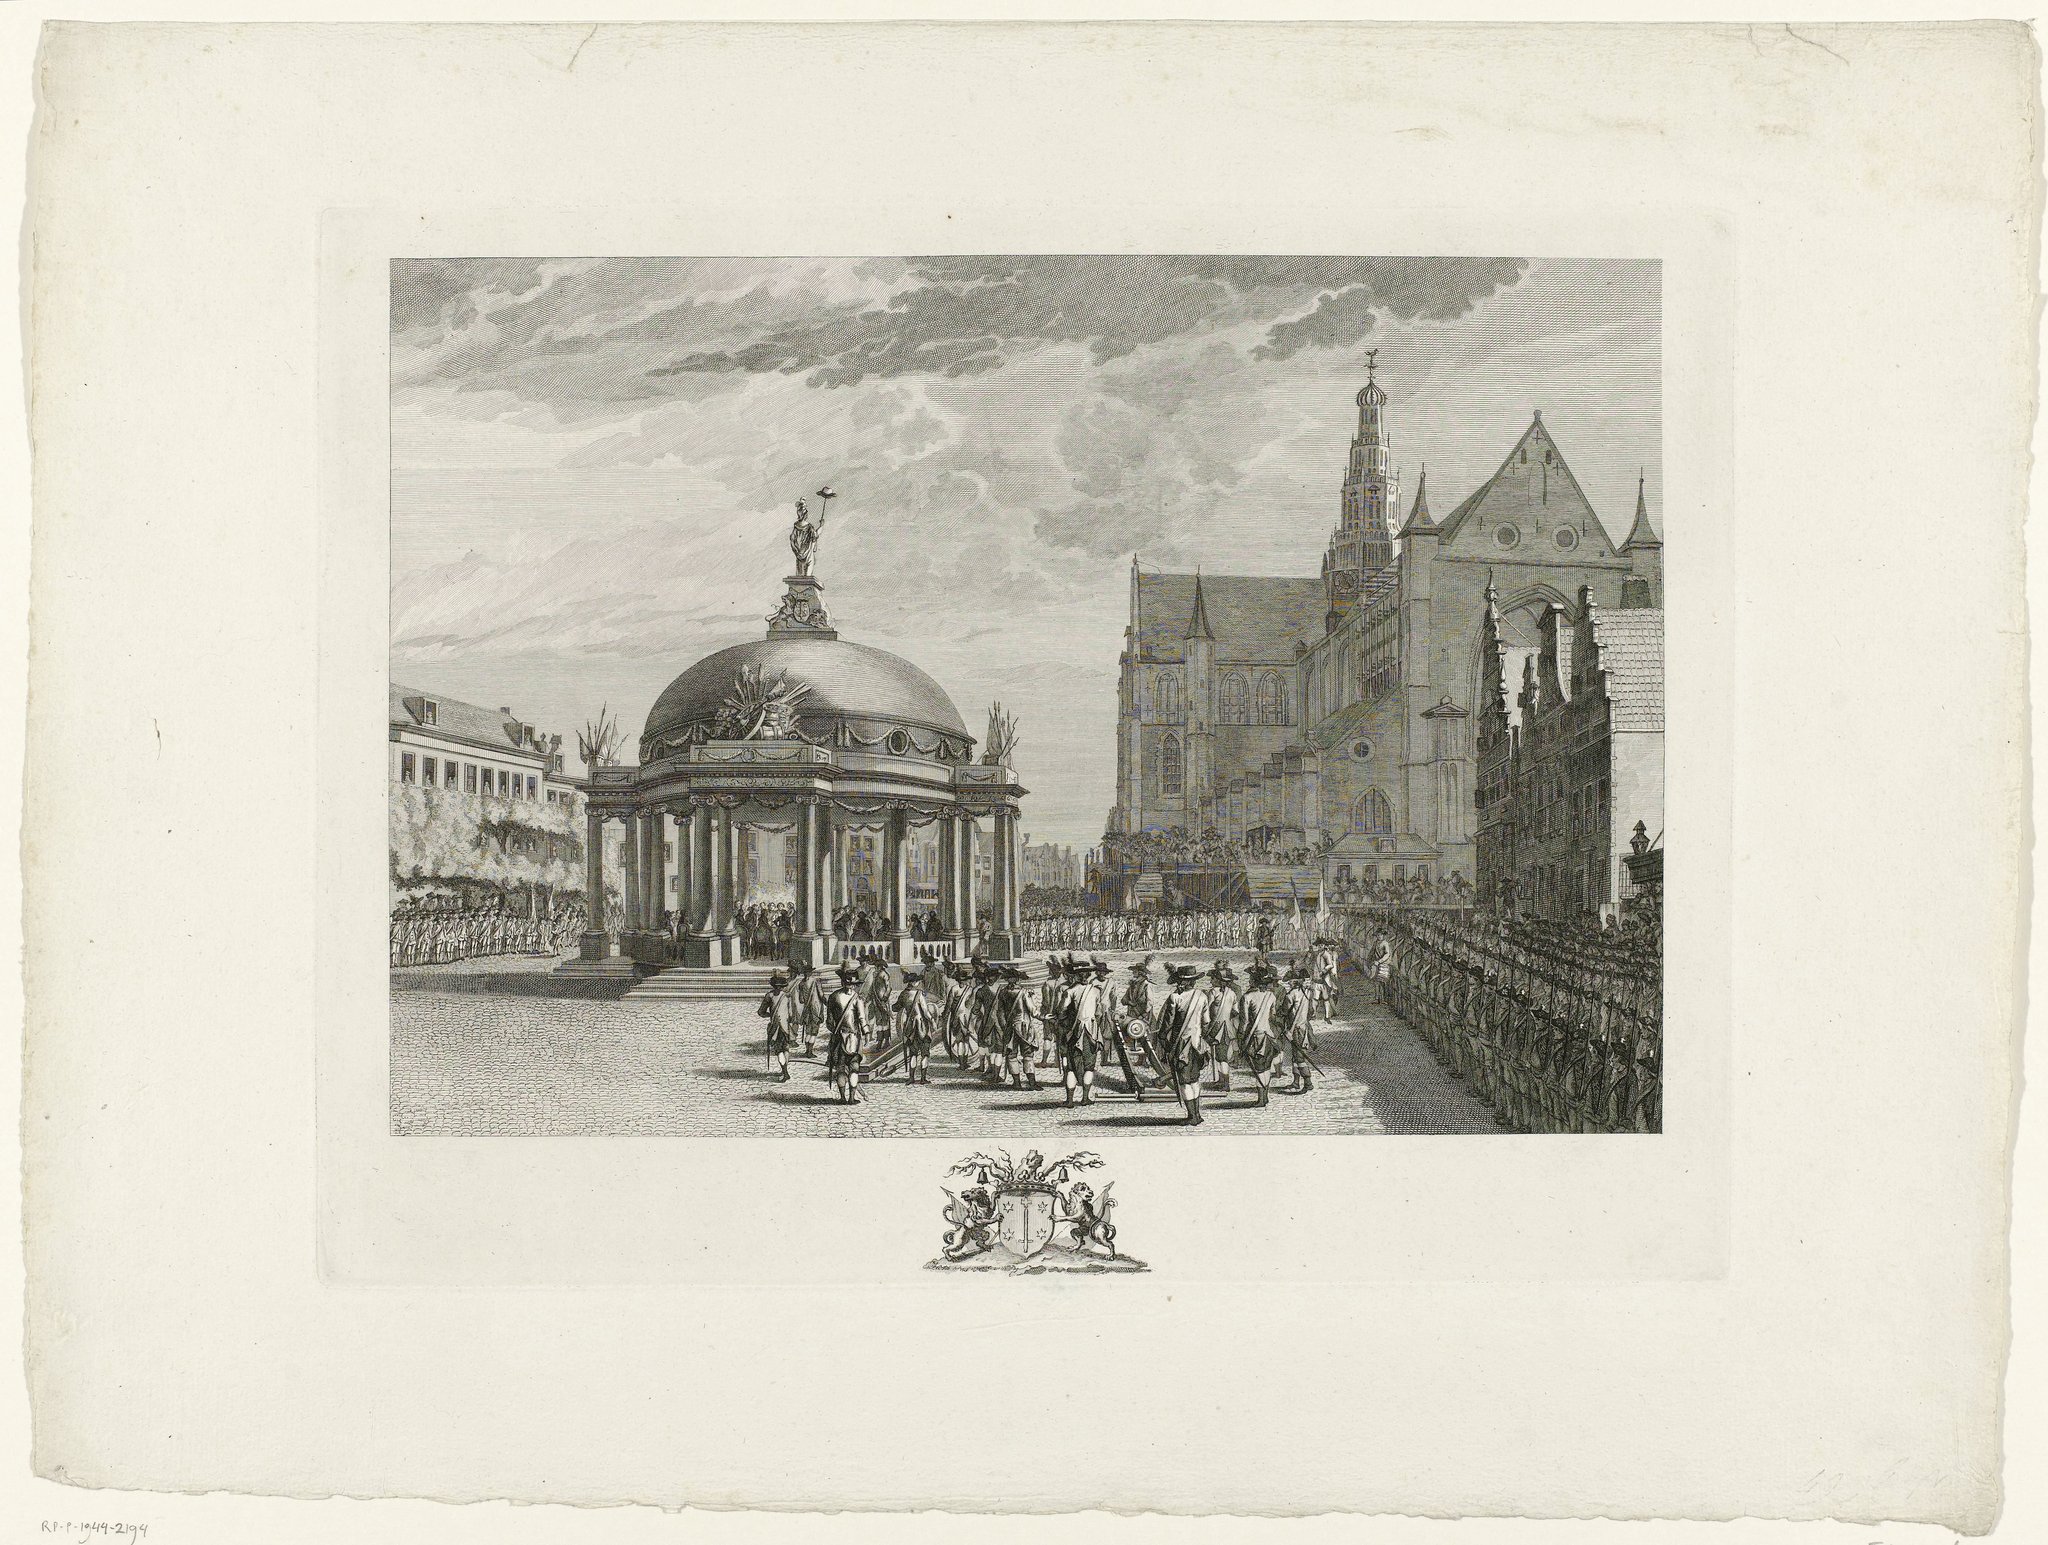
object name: print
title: Beëdiging van het regeringsreglement in Haarlem, 1787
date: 1787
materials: paper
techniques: engraving, etching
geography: northern netherlands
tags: proclamation of new government, warfare; military affairs (+ citizen soldiery, civil guard, citizen militia), patriots (1780-1795)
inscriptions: collector's mark: Lugt 2228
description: Plechtige ceremonie met de beëdiging van het nieuwe regeringsreglement in een tempel opgericht op de Grote Markt te Haarlem, 5 september 1787. Om het plein staan schutterijen opgesteld, bij de tempel enkele stukken geschut. In de marge het stadswapen van Haarlem.